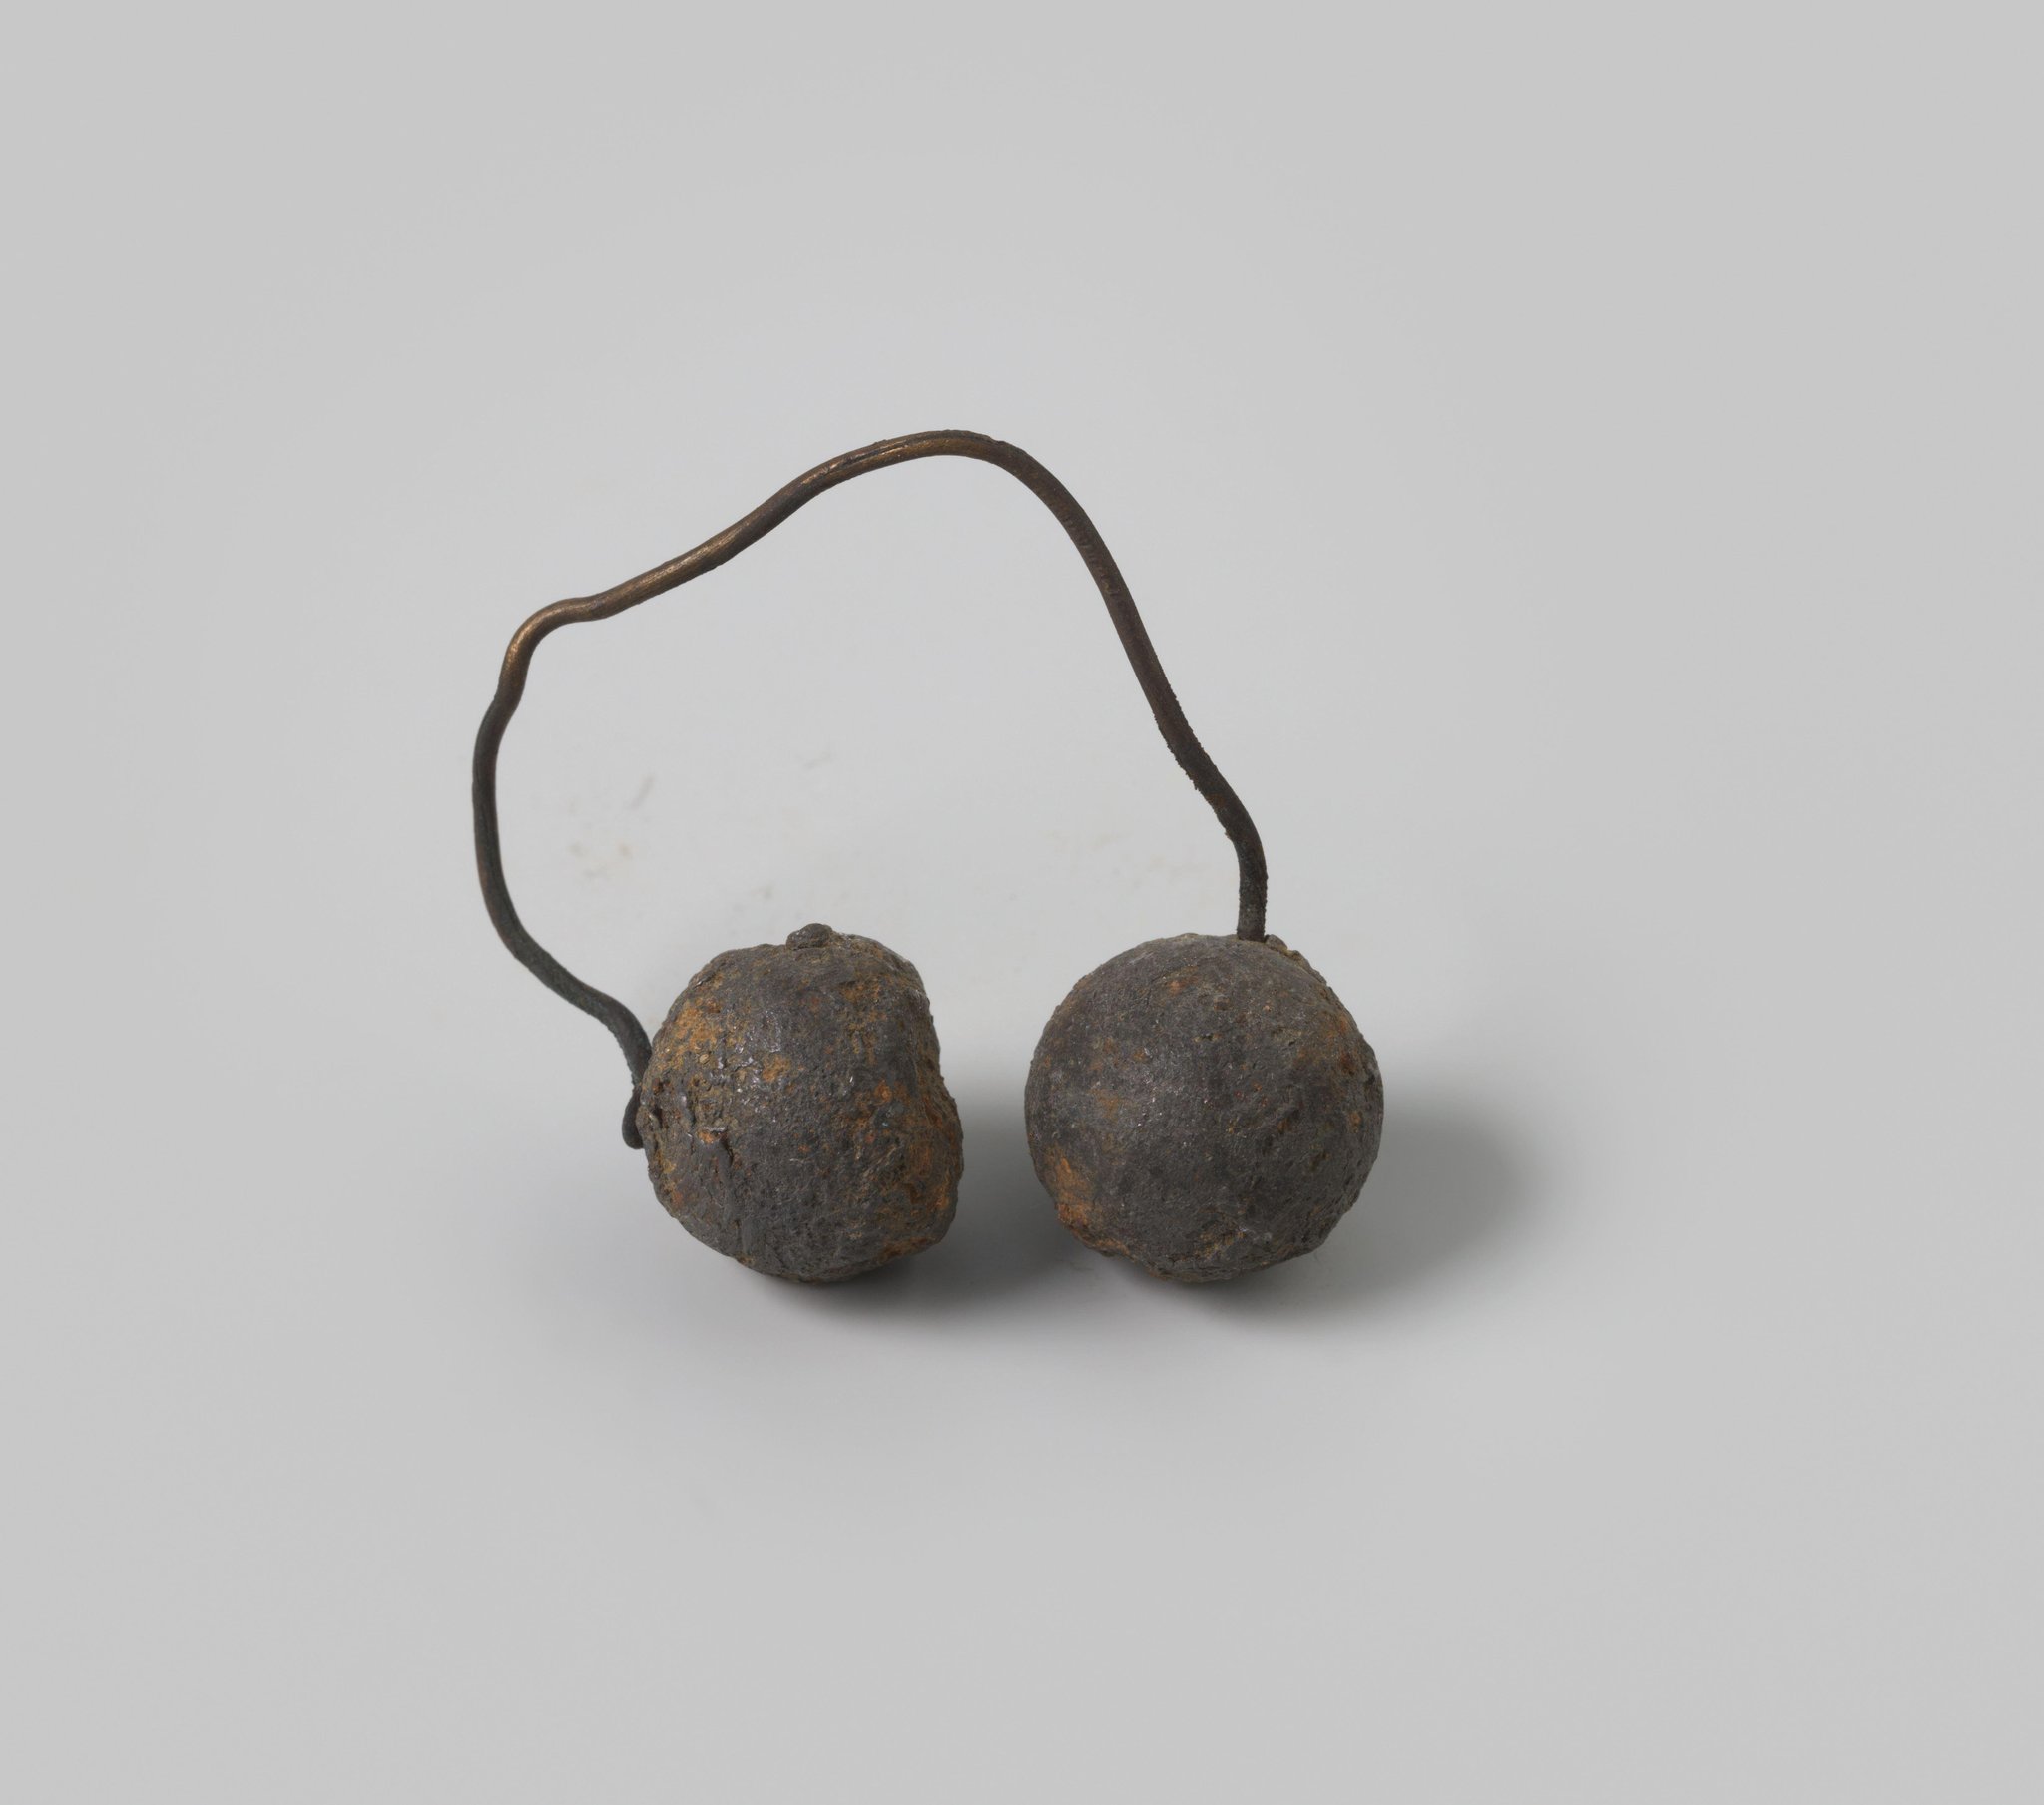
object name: chain shot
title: Kettingkogel uit het wrak van de Oost-Indiëvaarder Hollandia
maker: Anonymous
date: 1700-1743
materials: lead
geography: netherlands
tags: verenigde oostindische compagnie, hollandia (schip), annet